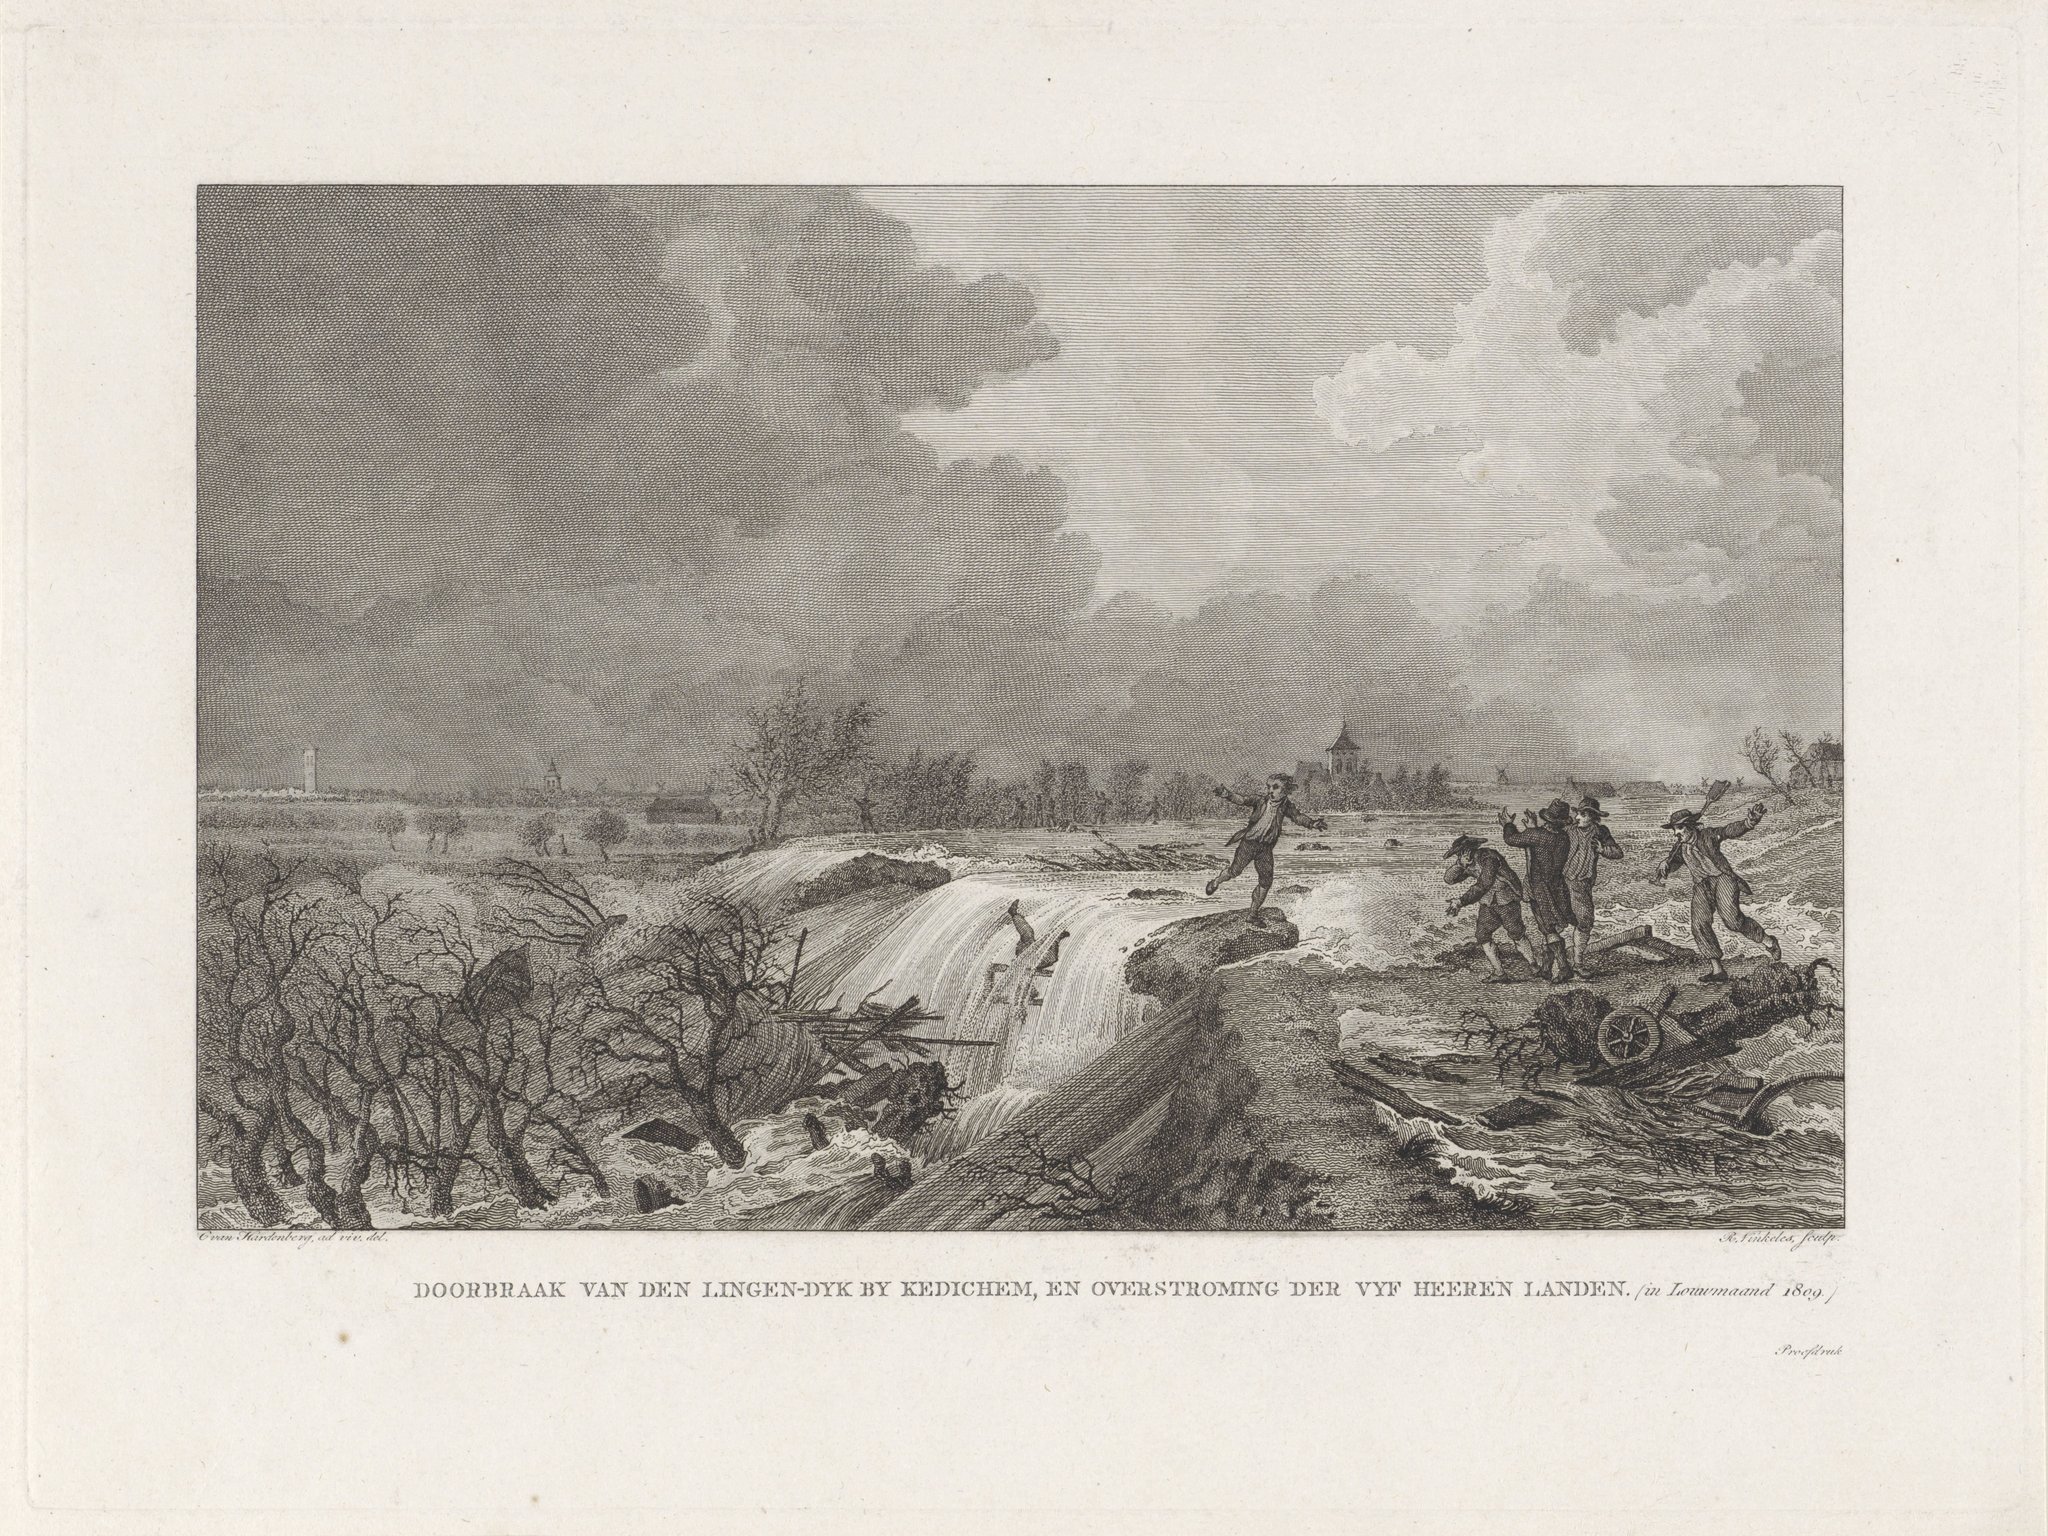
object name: print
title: Overstroming van de Linge bij Kedichem, 1809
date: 1809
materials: paper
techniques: engraving, etching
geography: amsterdam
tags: drift ice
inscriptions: collector's mark: Lugt 2233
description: Illustratie voor: Ewijk, Hendrik. Geschiedkundig verslag der dijkbreuken en overstroomingen in Holland, in 1809. Amsterdam: J. Allart en J. Ruys, 1809.